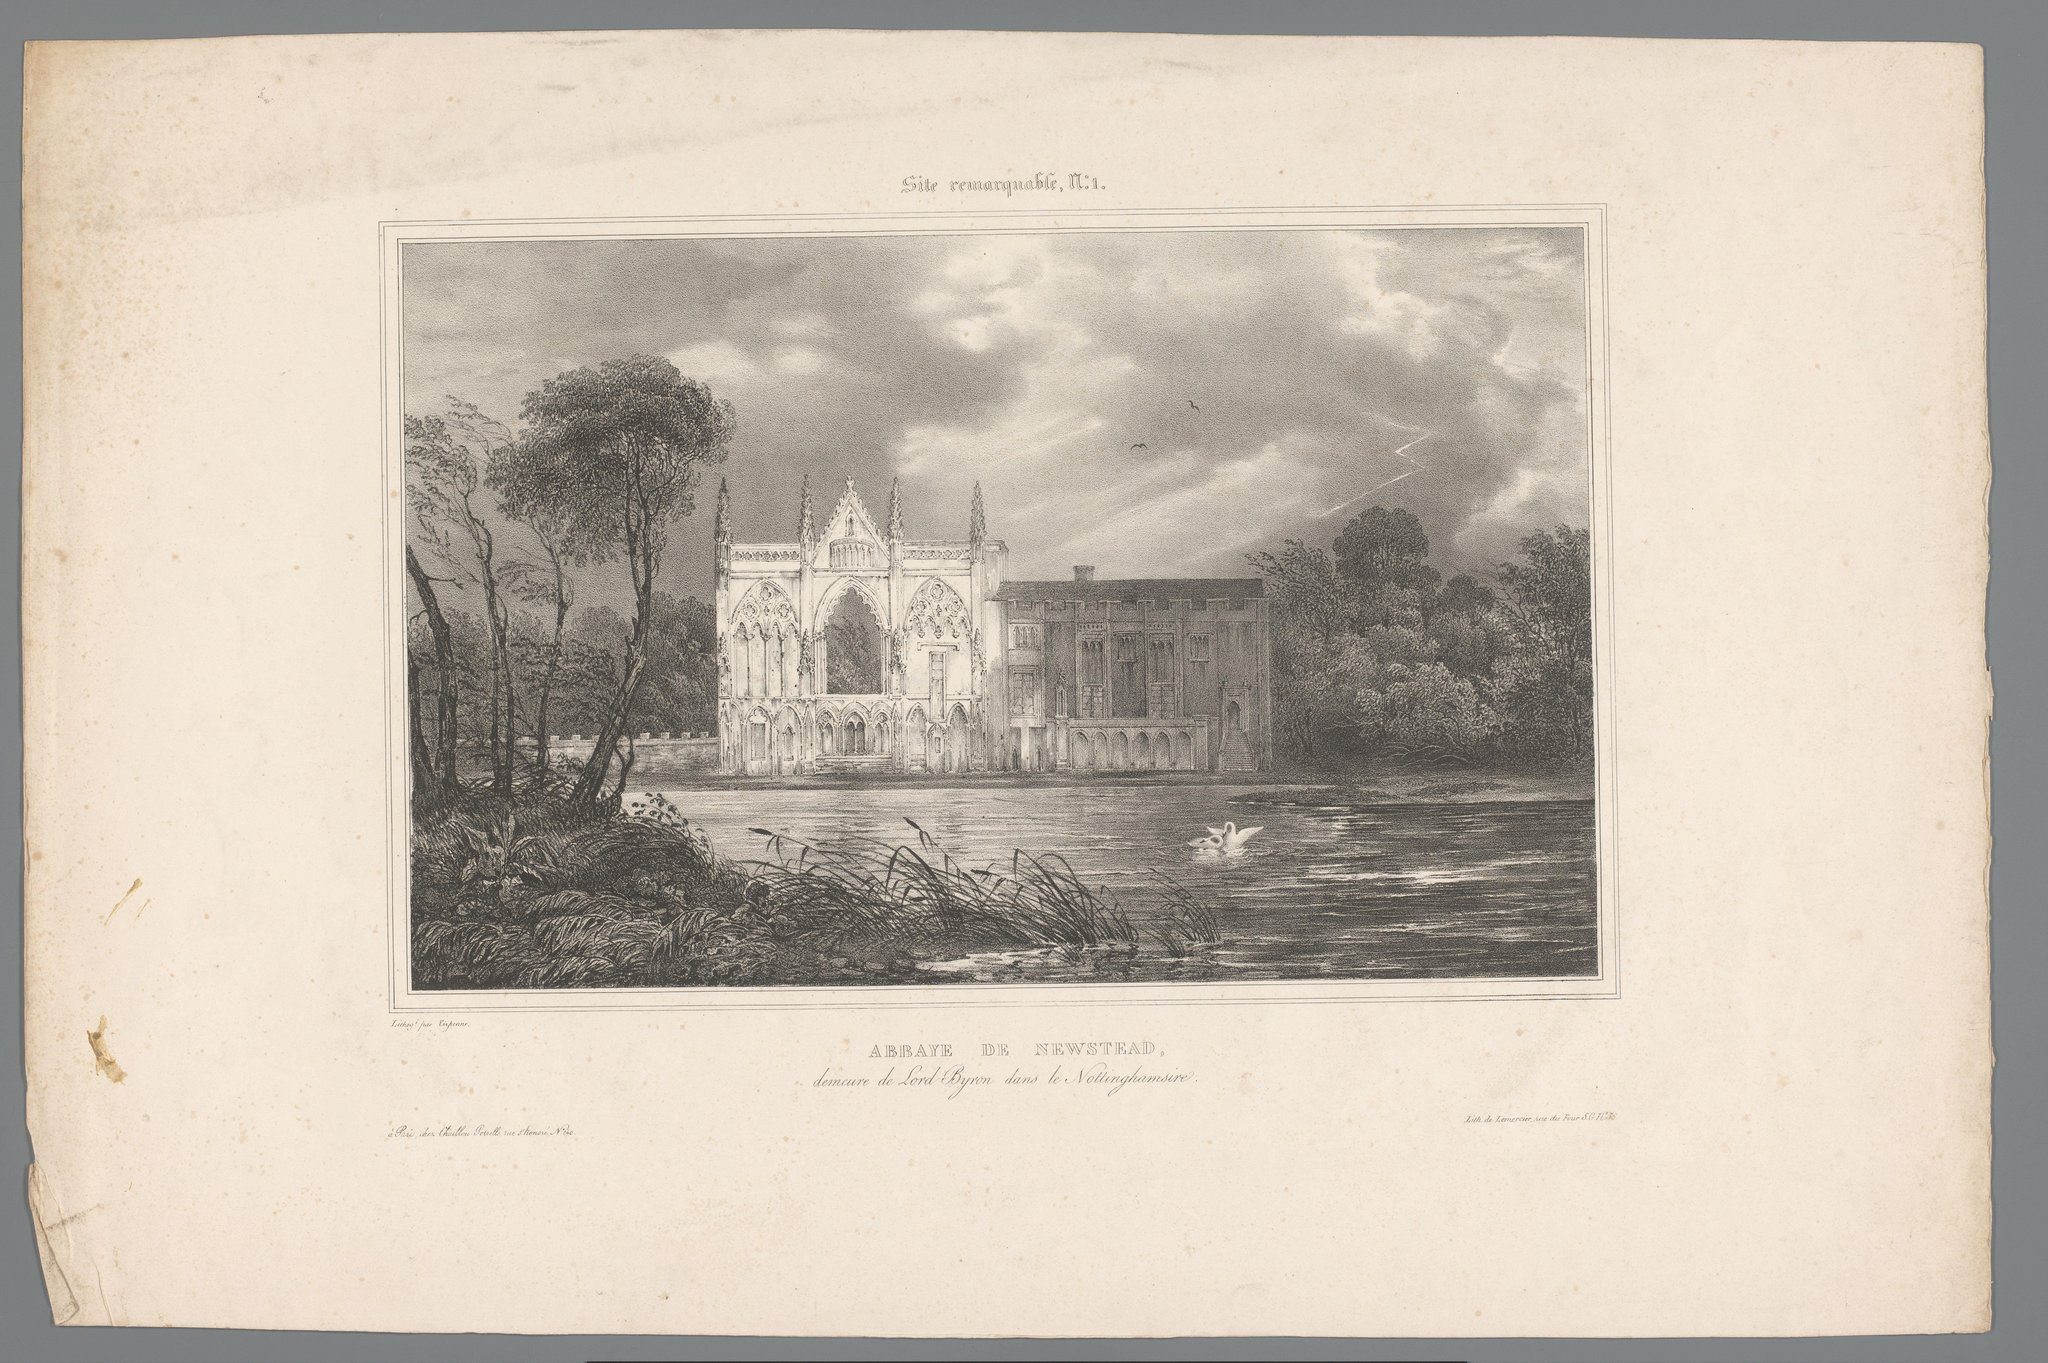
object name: print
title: Site remarquable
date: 1821-1833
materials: paper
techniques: lithograph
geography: paris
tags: london, lord byron, country-house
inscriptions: collector's mark: Lugt 2228